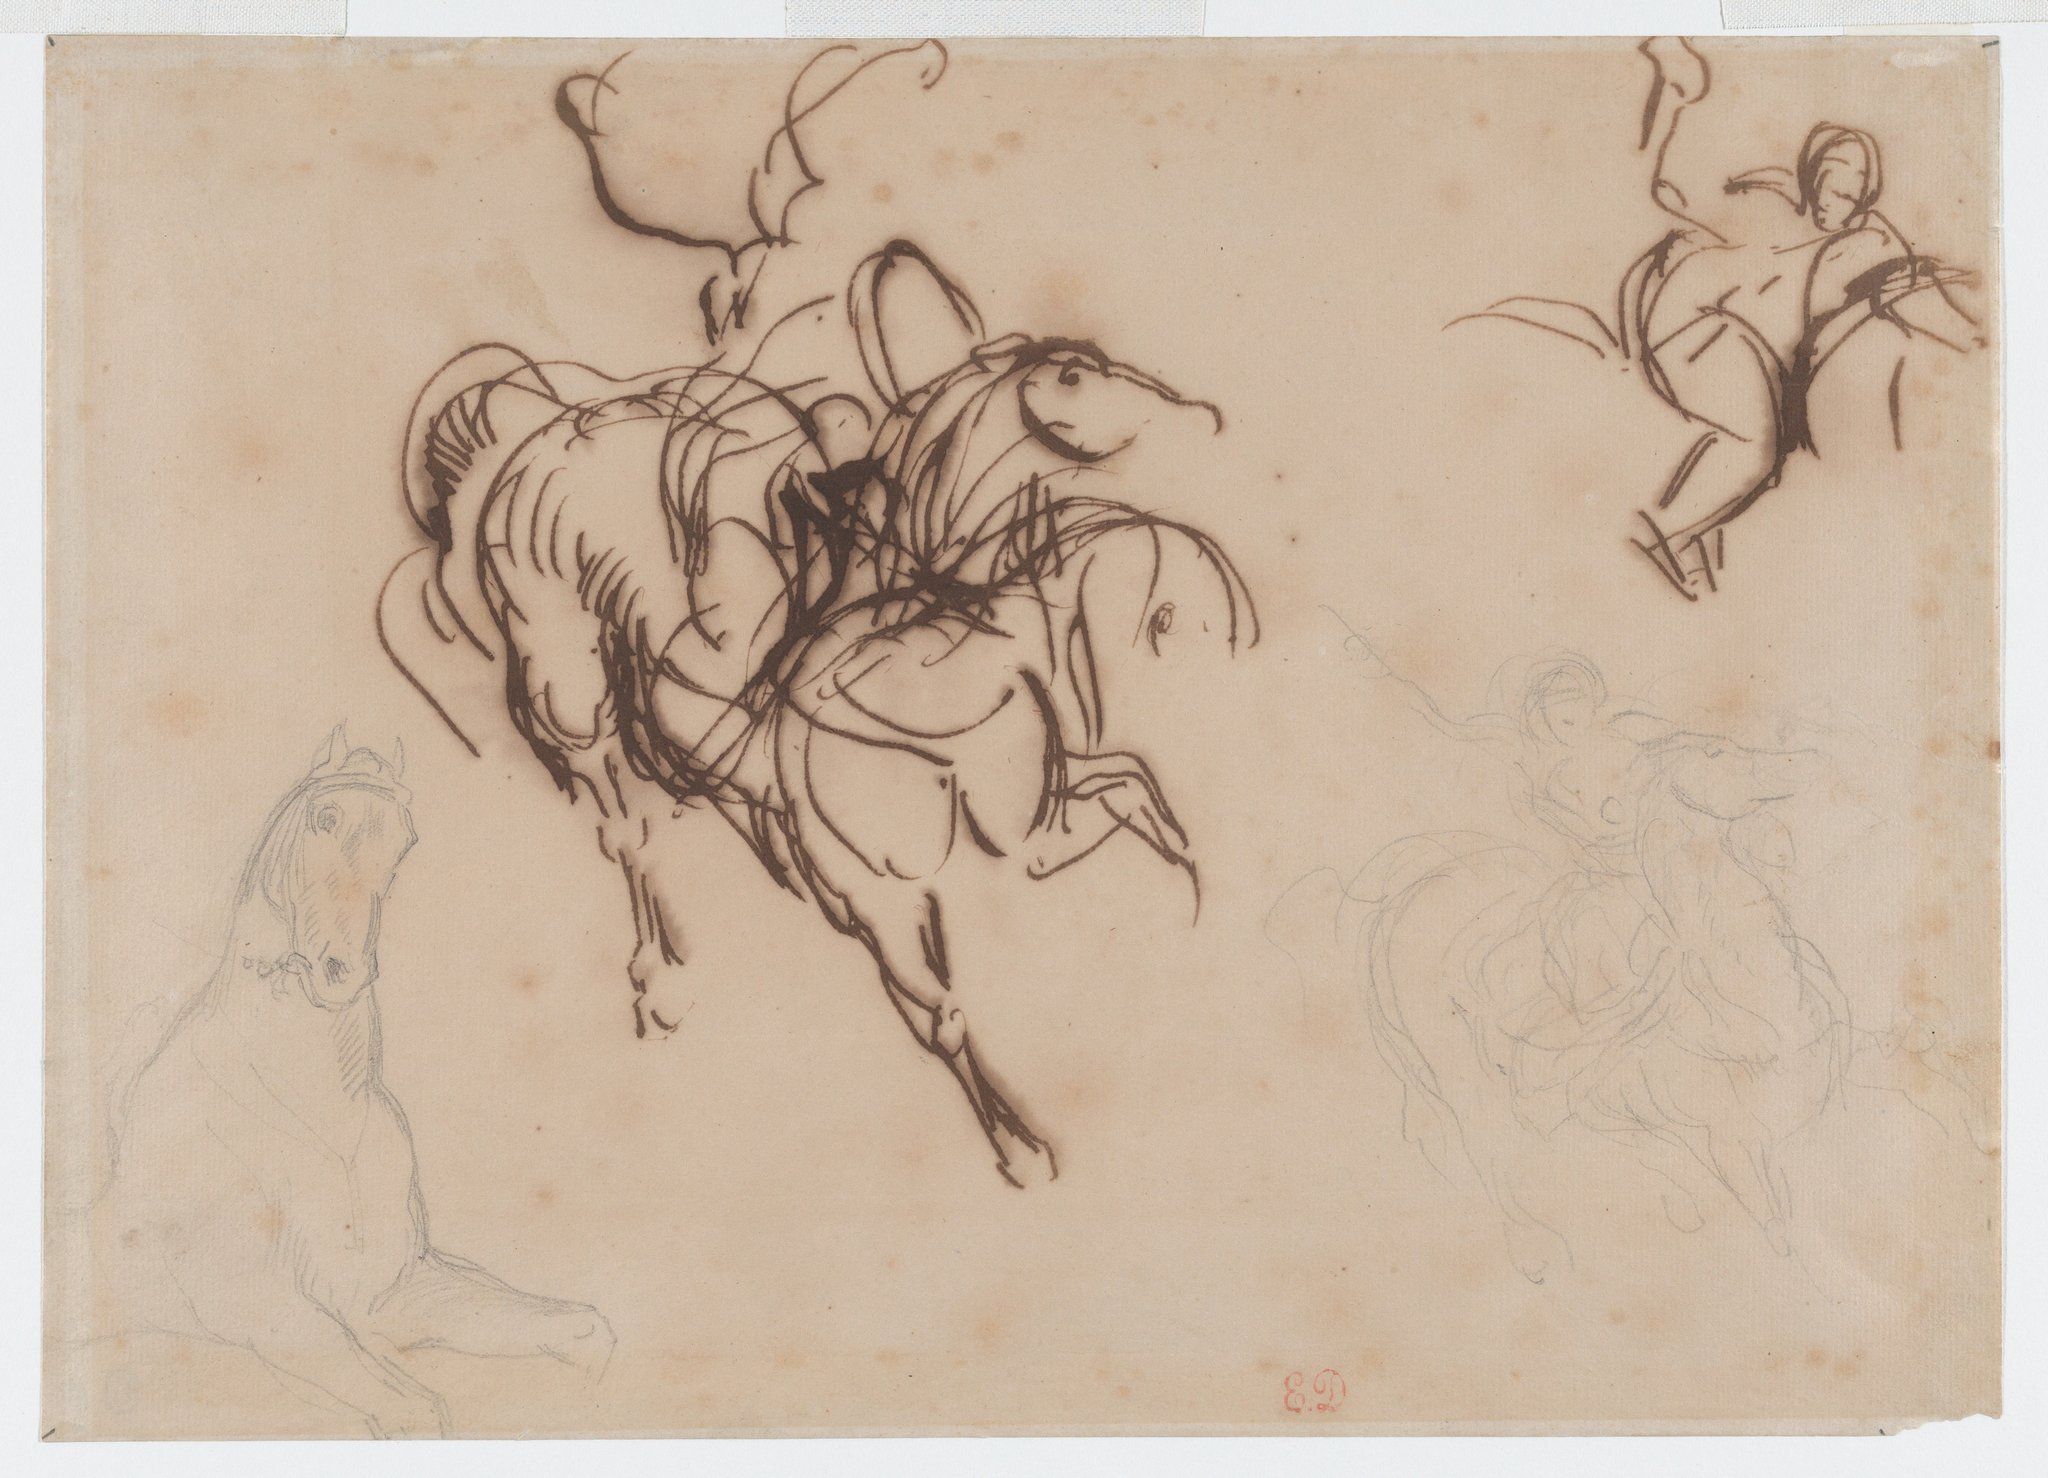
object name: drawing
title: Studies of a Horse and Rider for "Heliodorus Driven from the Temple"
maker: eugène delacroix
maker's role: artist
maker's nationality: french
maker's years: 1798-1863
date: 1849-1850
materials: graphite, ink, iron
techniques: pen